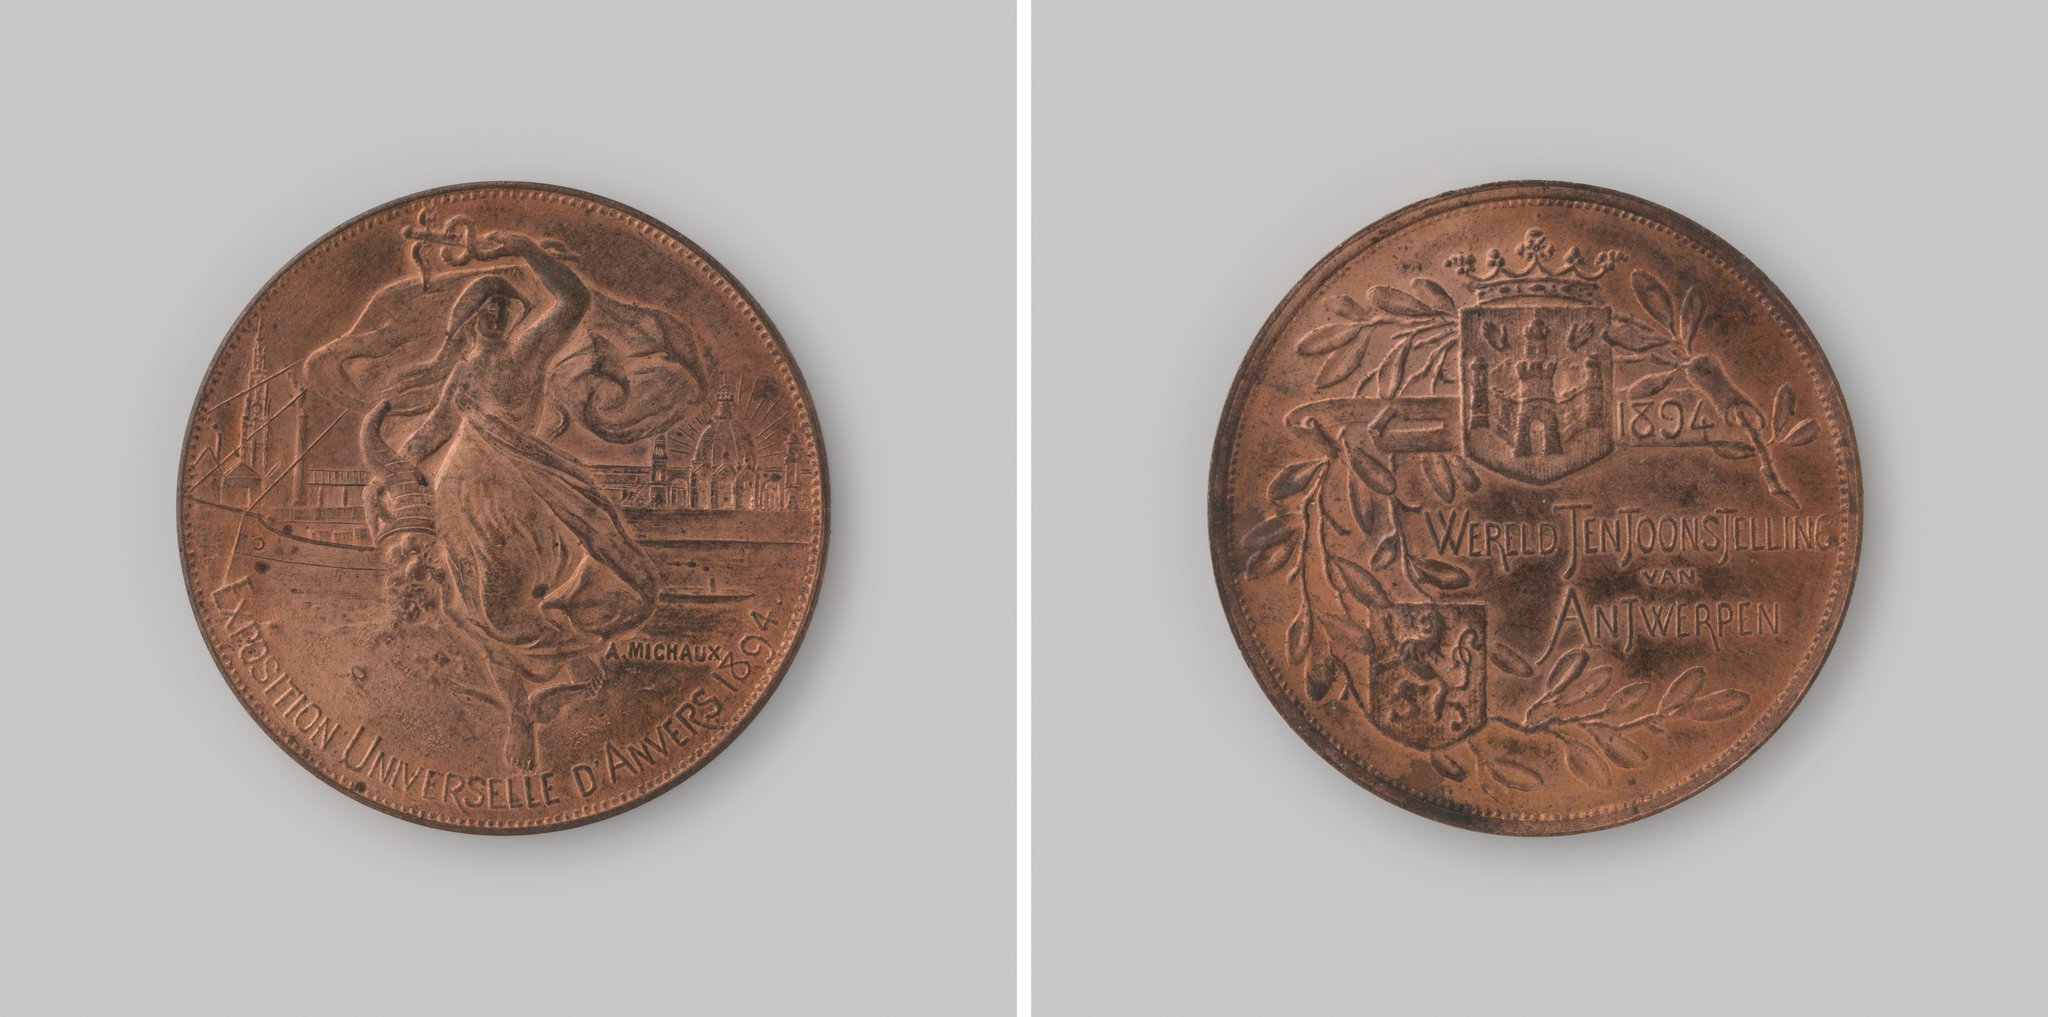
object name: history medal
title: Wereldtentoonstelling te Antwerpen 1894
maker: alphonse michaux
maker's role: medailleur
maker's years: 1860-1928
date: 1894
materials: copper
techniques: striking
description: Bronzen penning, op de voorzijde een dansende vrouw met mercuriusstaf en hoorn des overvloeds, Antwerpen vanaf de Schelde op de achtergrond, met oven omschrift, op de keerzijde twee regels tekst met boven en links een tak waaraan twee wapenschilden en een banderol.